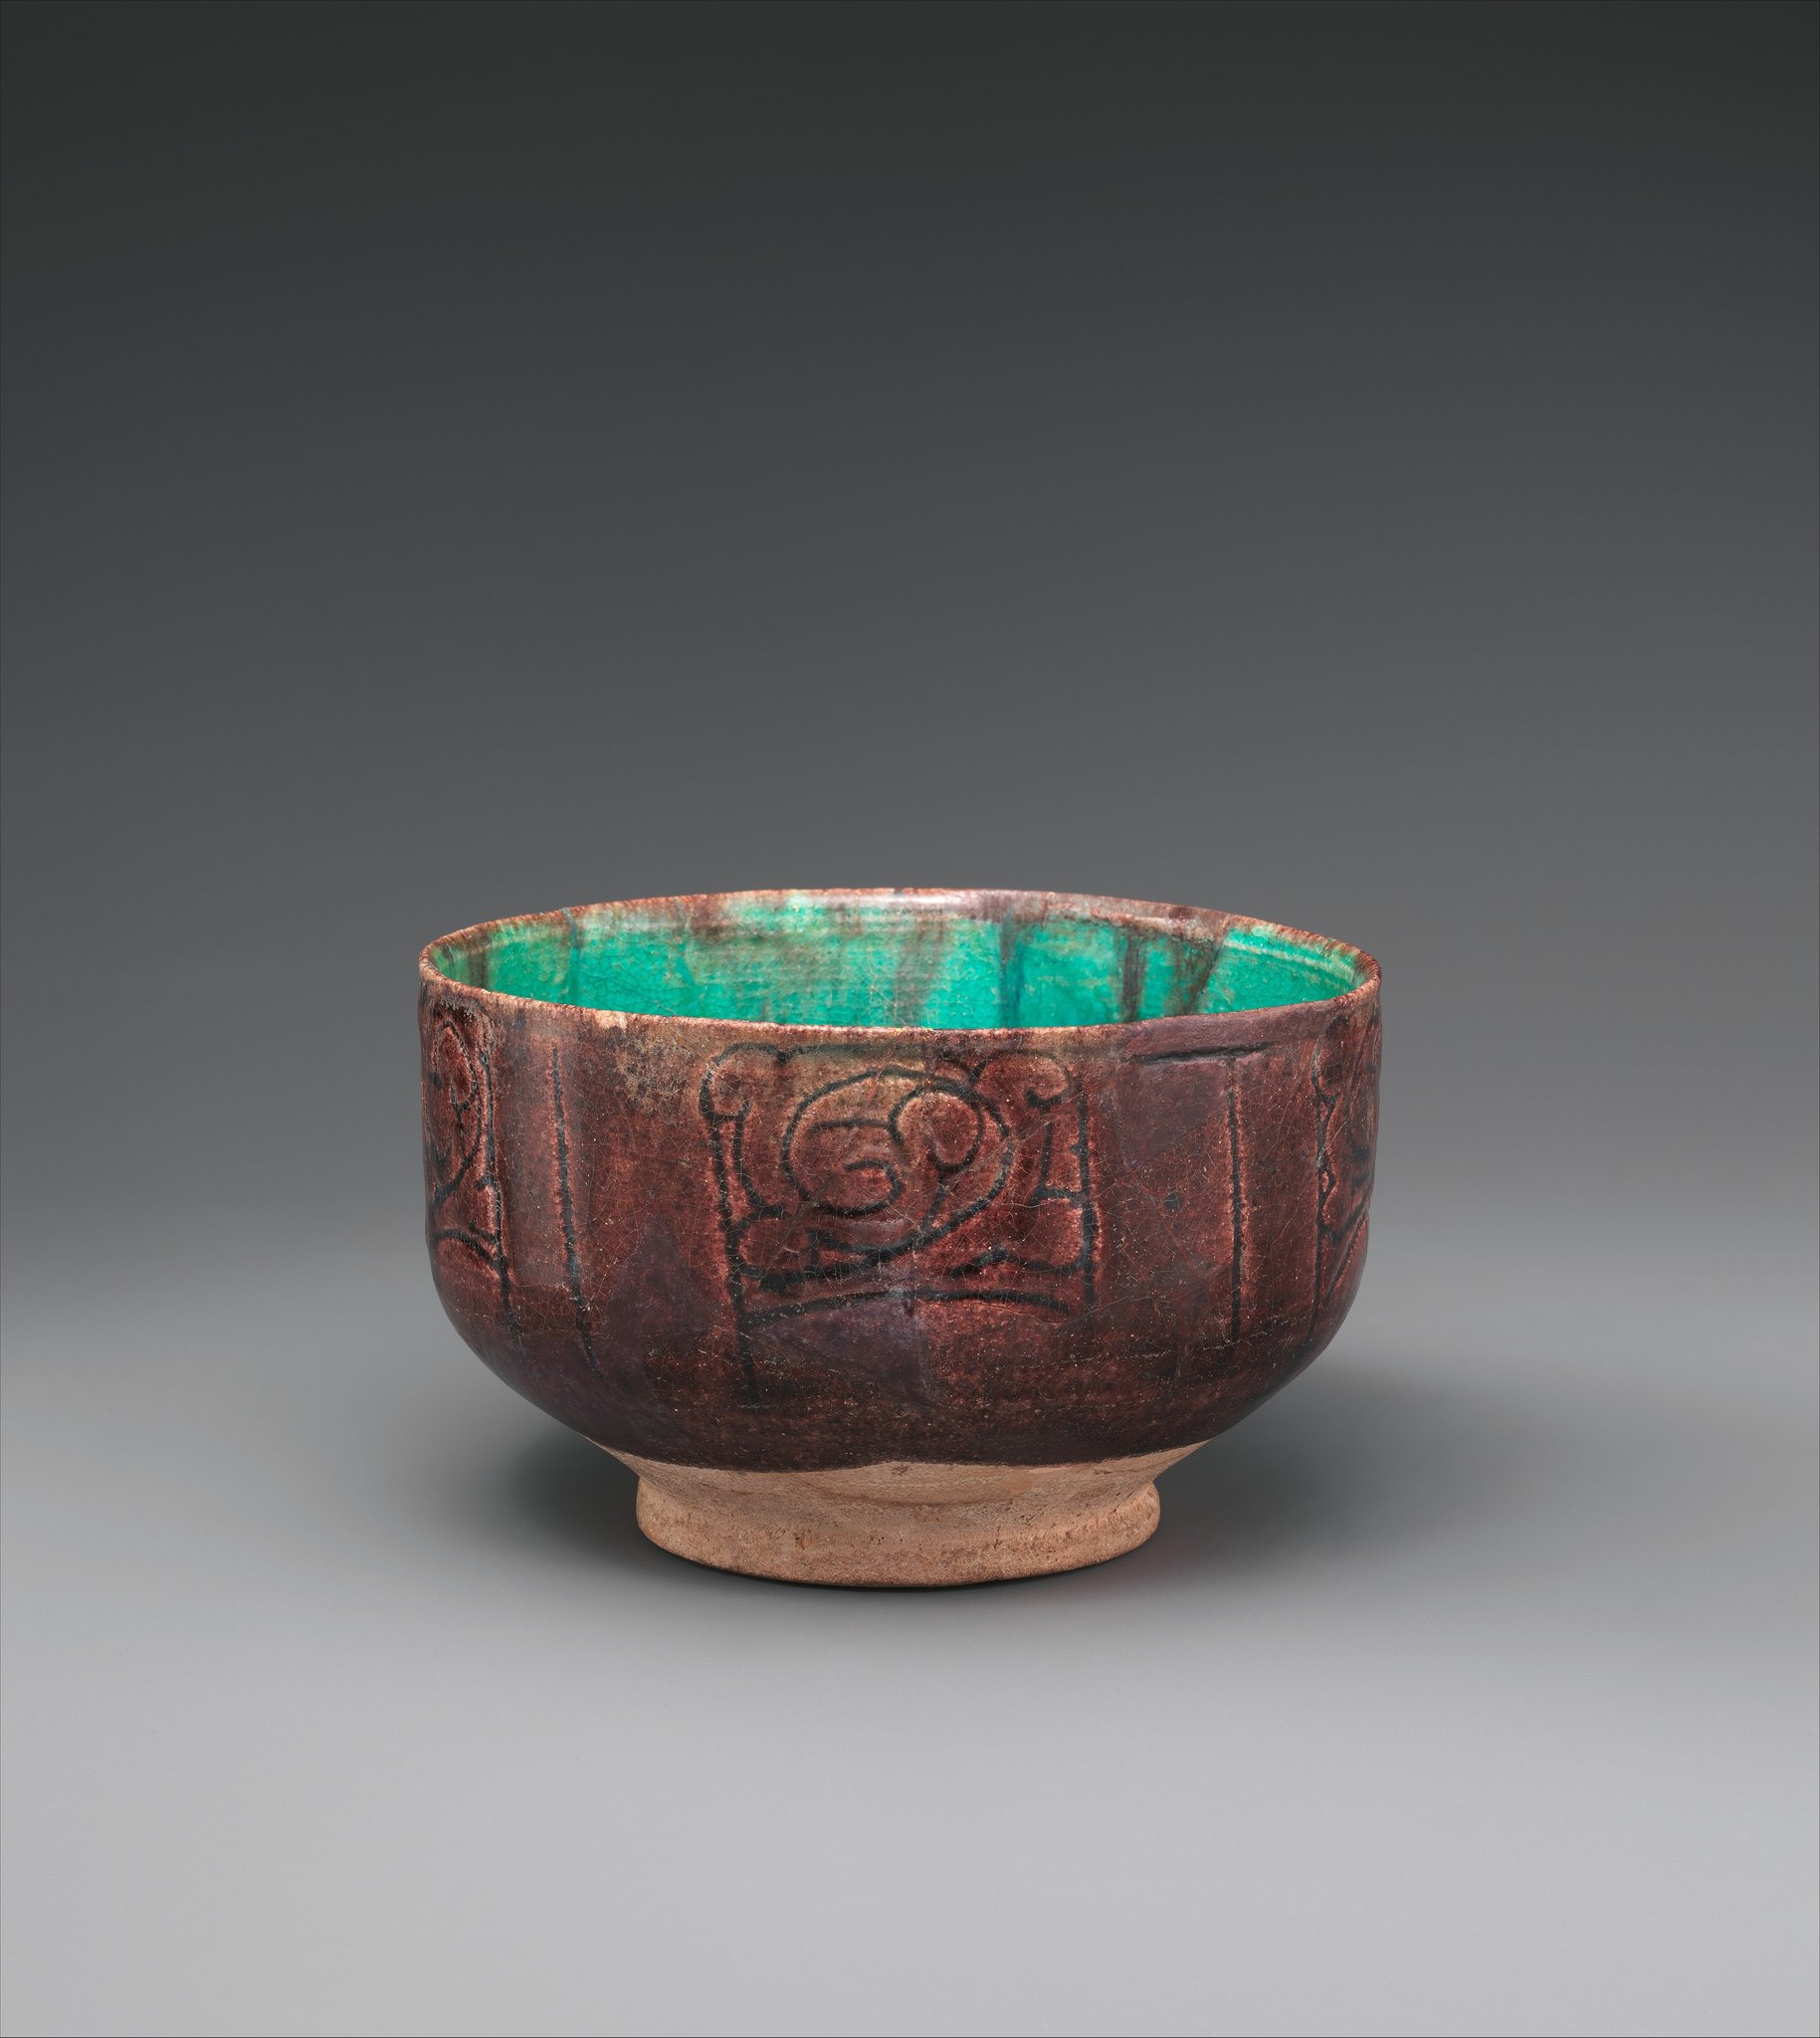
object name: bowl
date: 1067-1133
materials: stonepaste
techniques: glazing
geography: iran